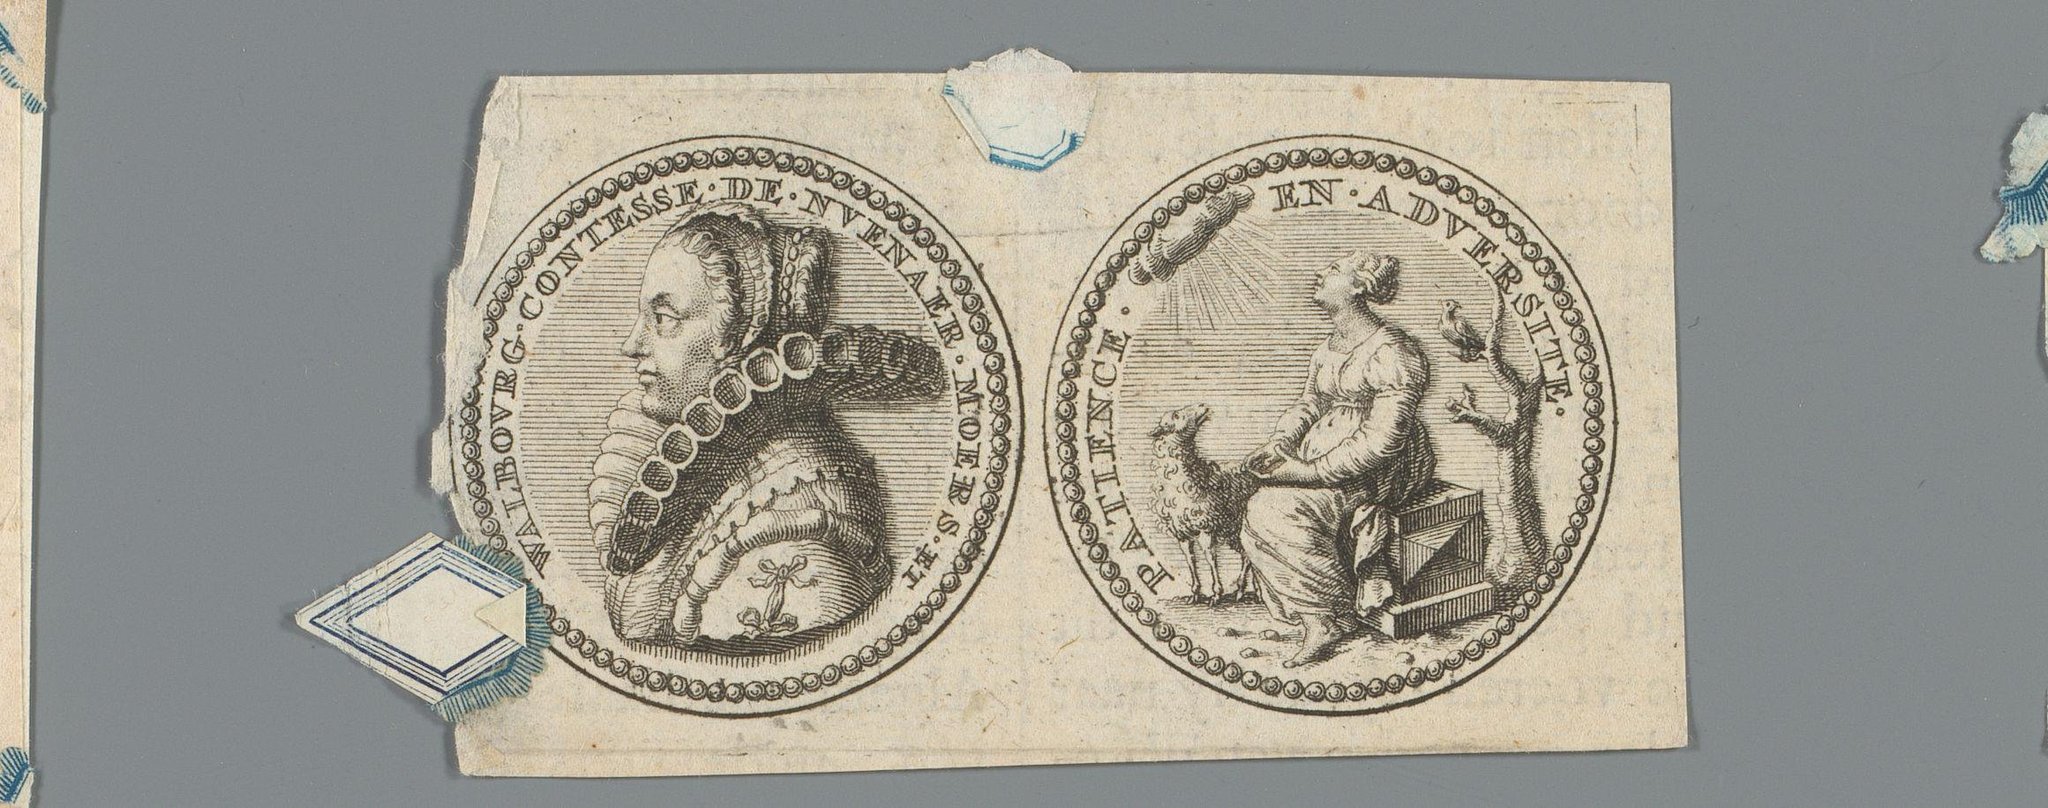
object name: book illustration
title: Voor- en achterzijde van een penning met het portret van Walburg van Nieuwenaar en de personificatie van geduld en tegenspoed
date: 1723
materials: paper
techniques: etching, letterpress printing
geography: the hague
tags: historical persons - bb - woman, patience; 'patienza' (ripa), adversity, misfortune, bad luck; 'fortuna infelice', 'infortunio' (ripa), coin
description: Prent uit: Loon, Gerard van. Beschryving der Nederlandsche Historipenningen: (...). Den Haag: Christiaan van Lom et al., 1723, dl. 1, p. 402.